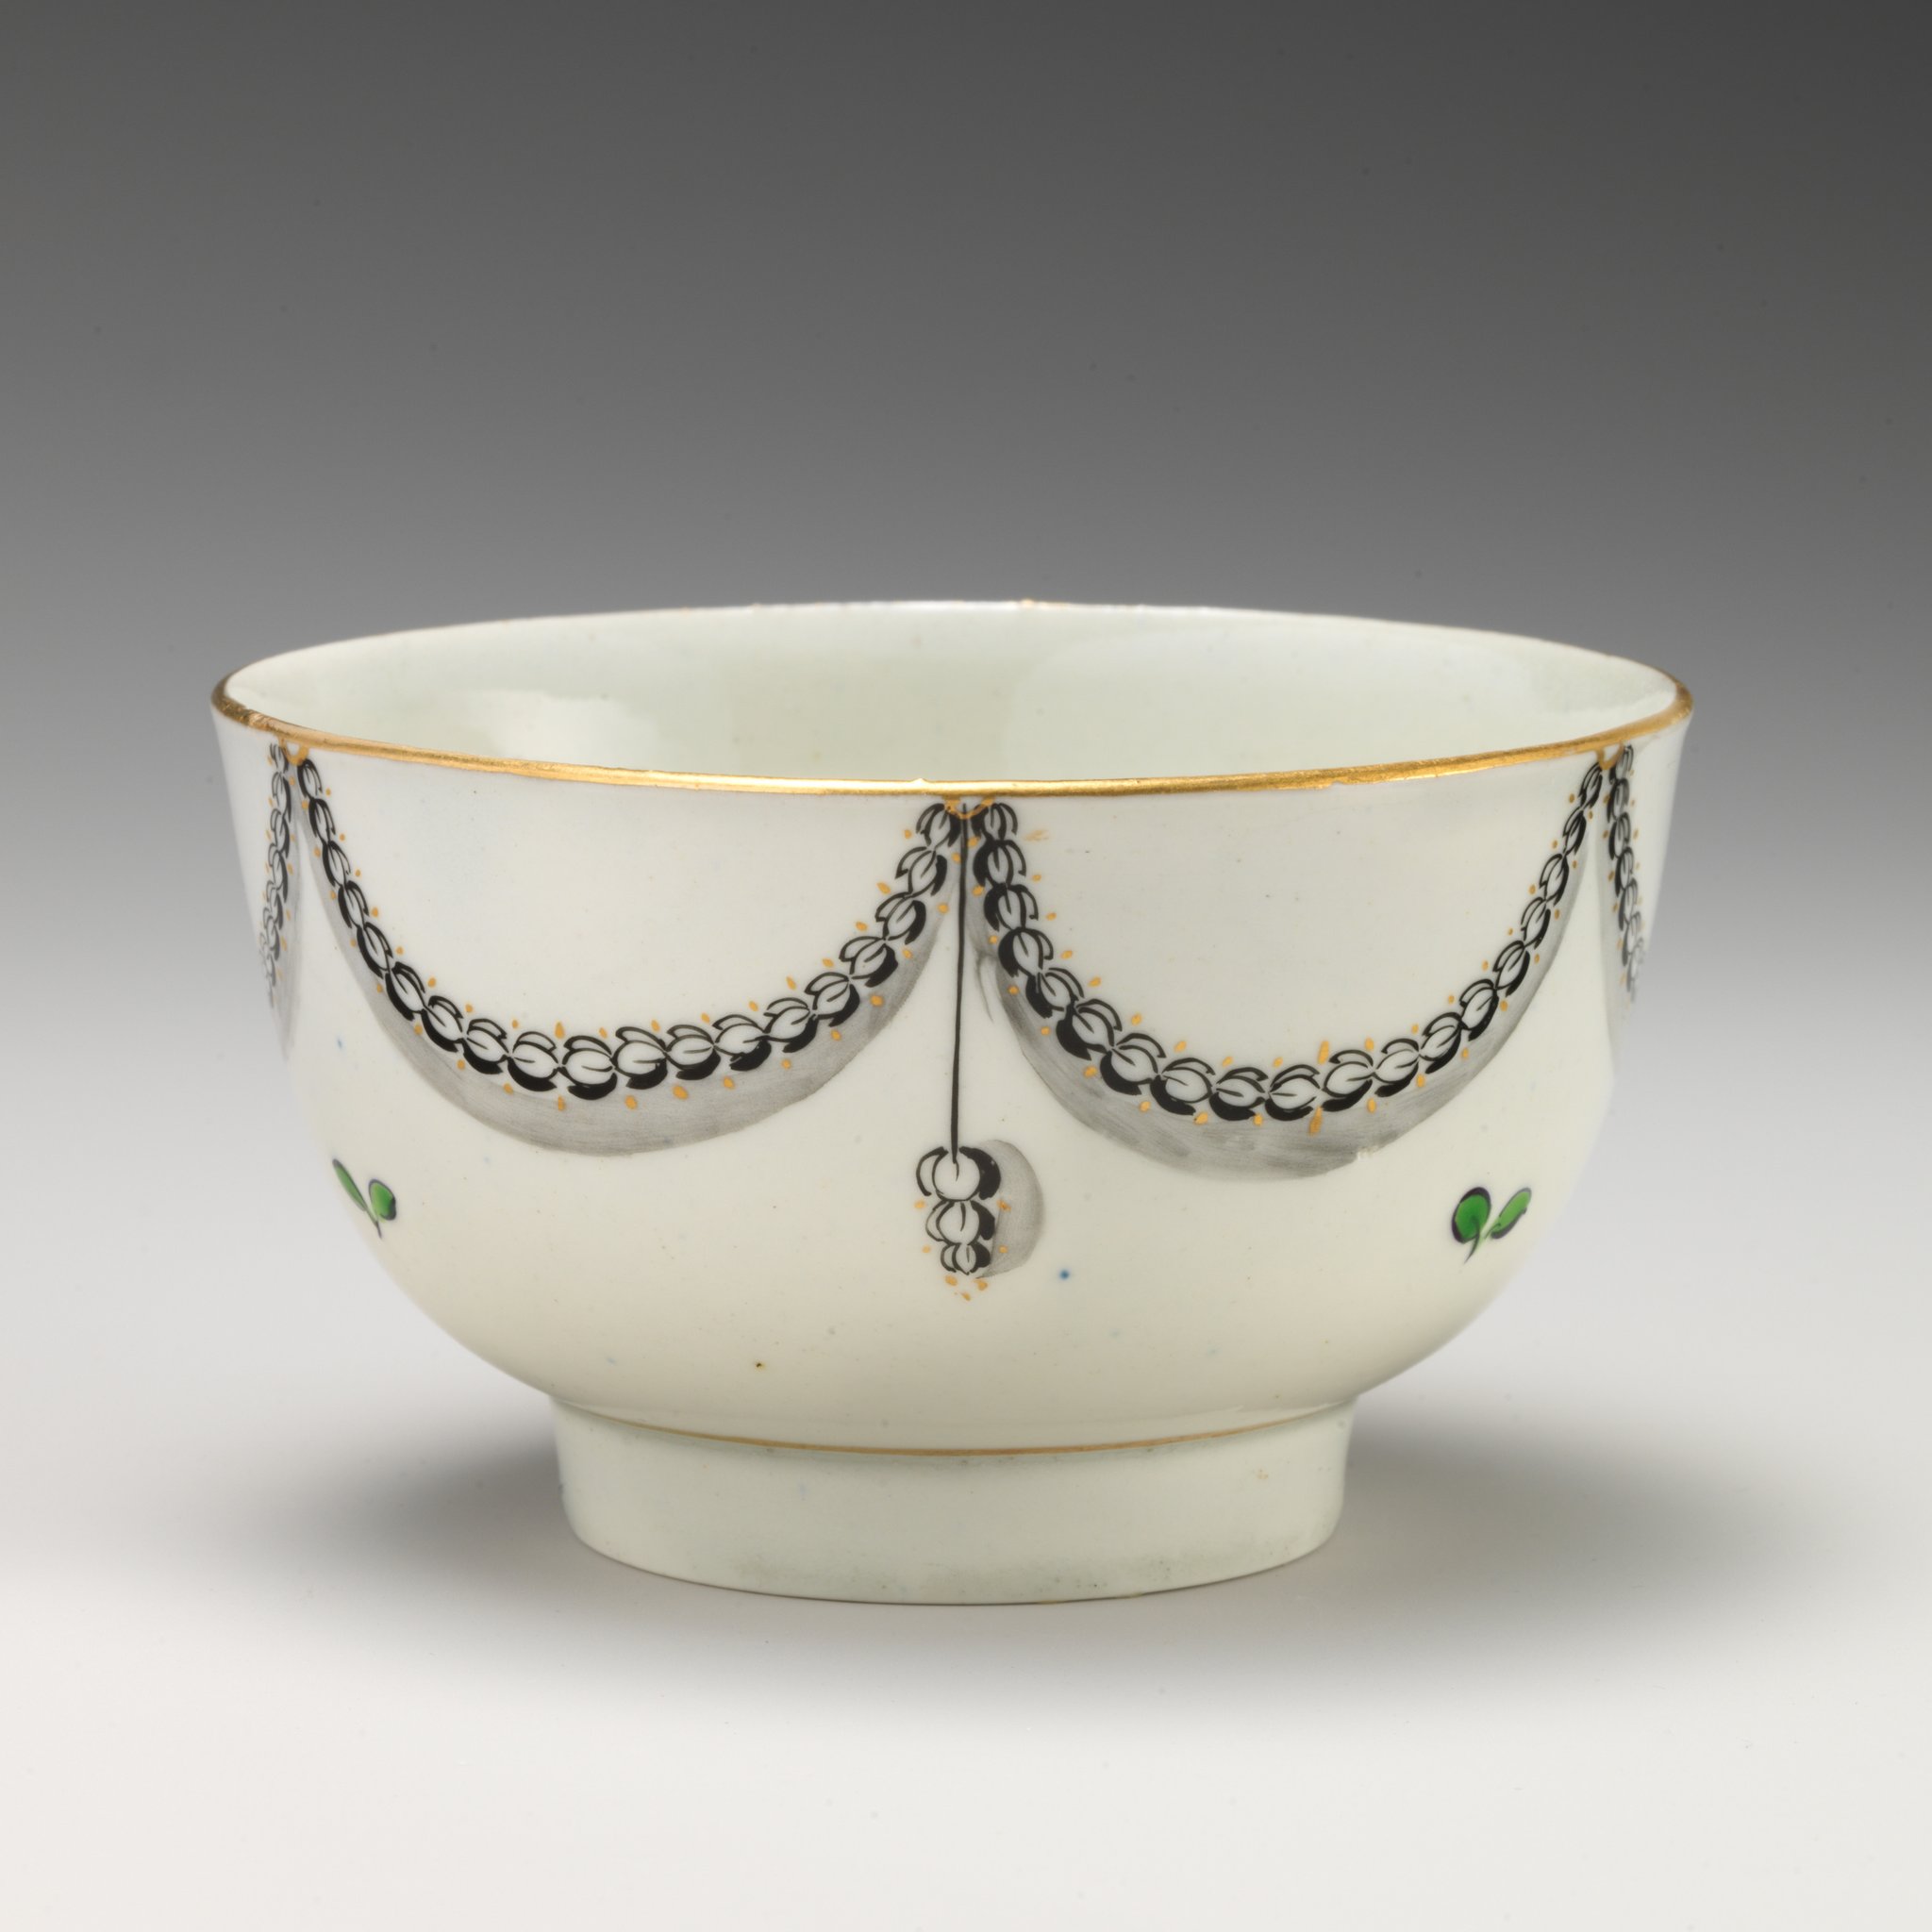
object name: bowl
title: Bowl (part of a service)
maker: caughley factory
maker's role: factory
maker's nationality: british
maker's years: 1772-1799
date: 1780-1790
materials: enamel, soft paste porcelain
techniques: gilding